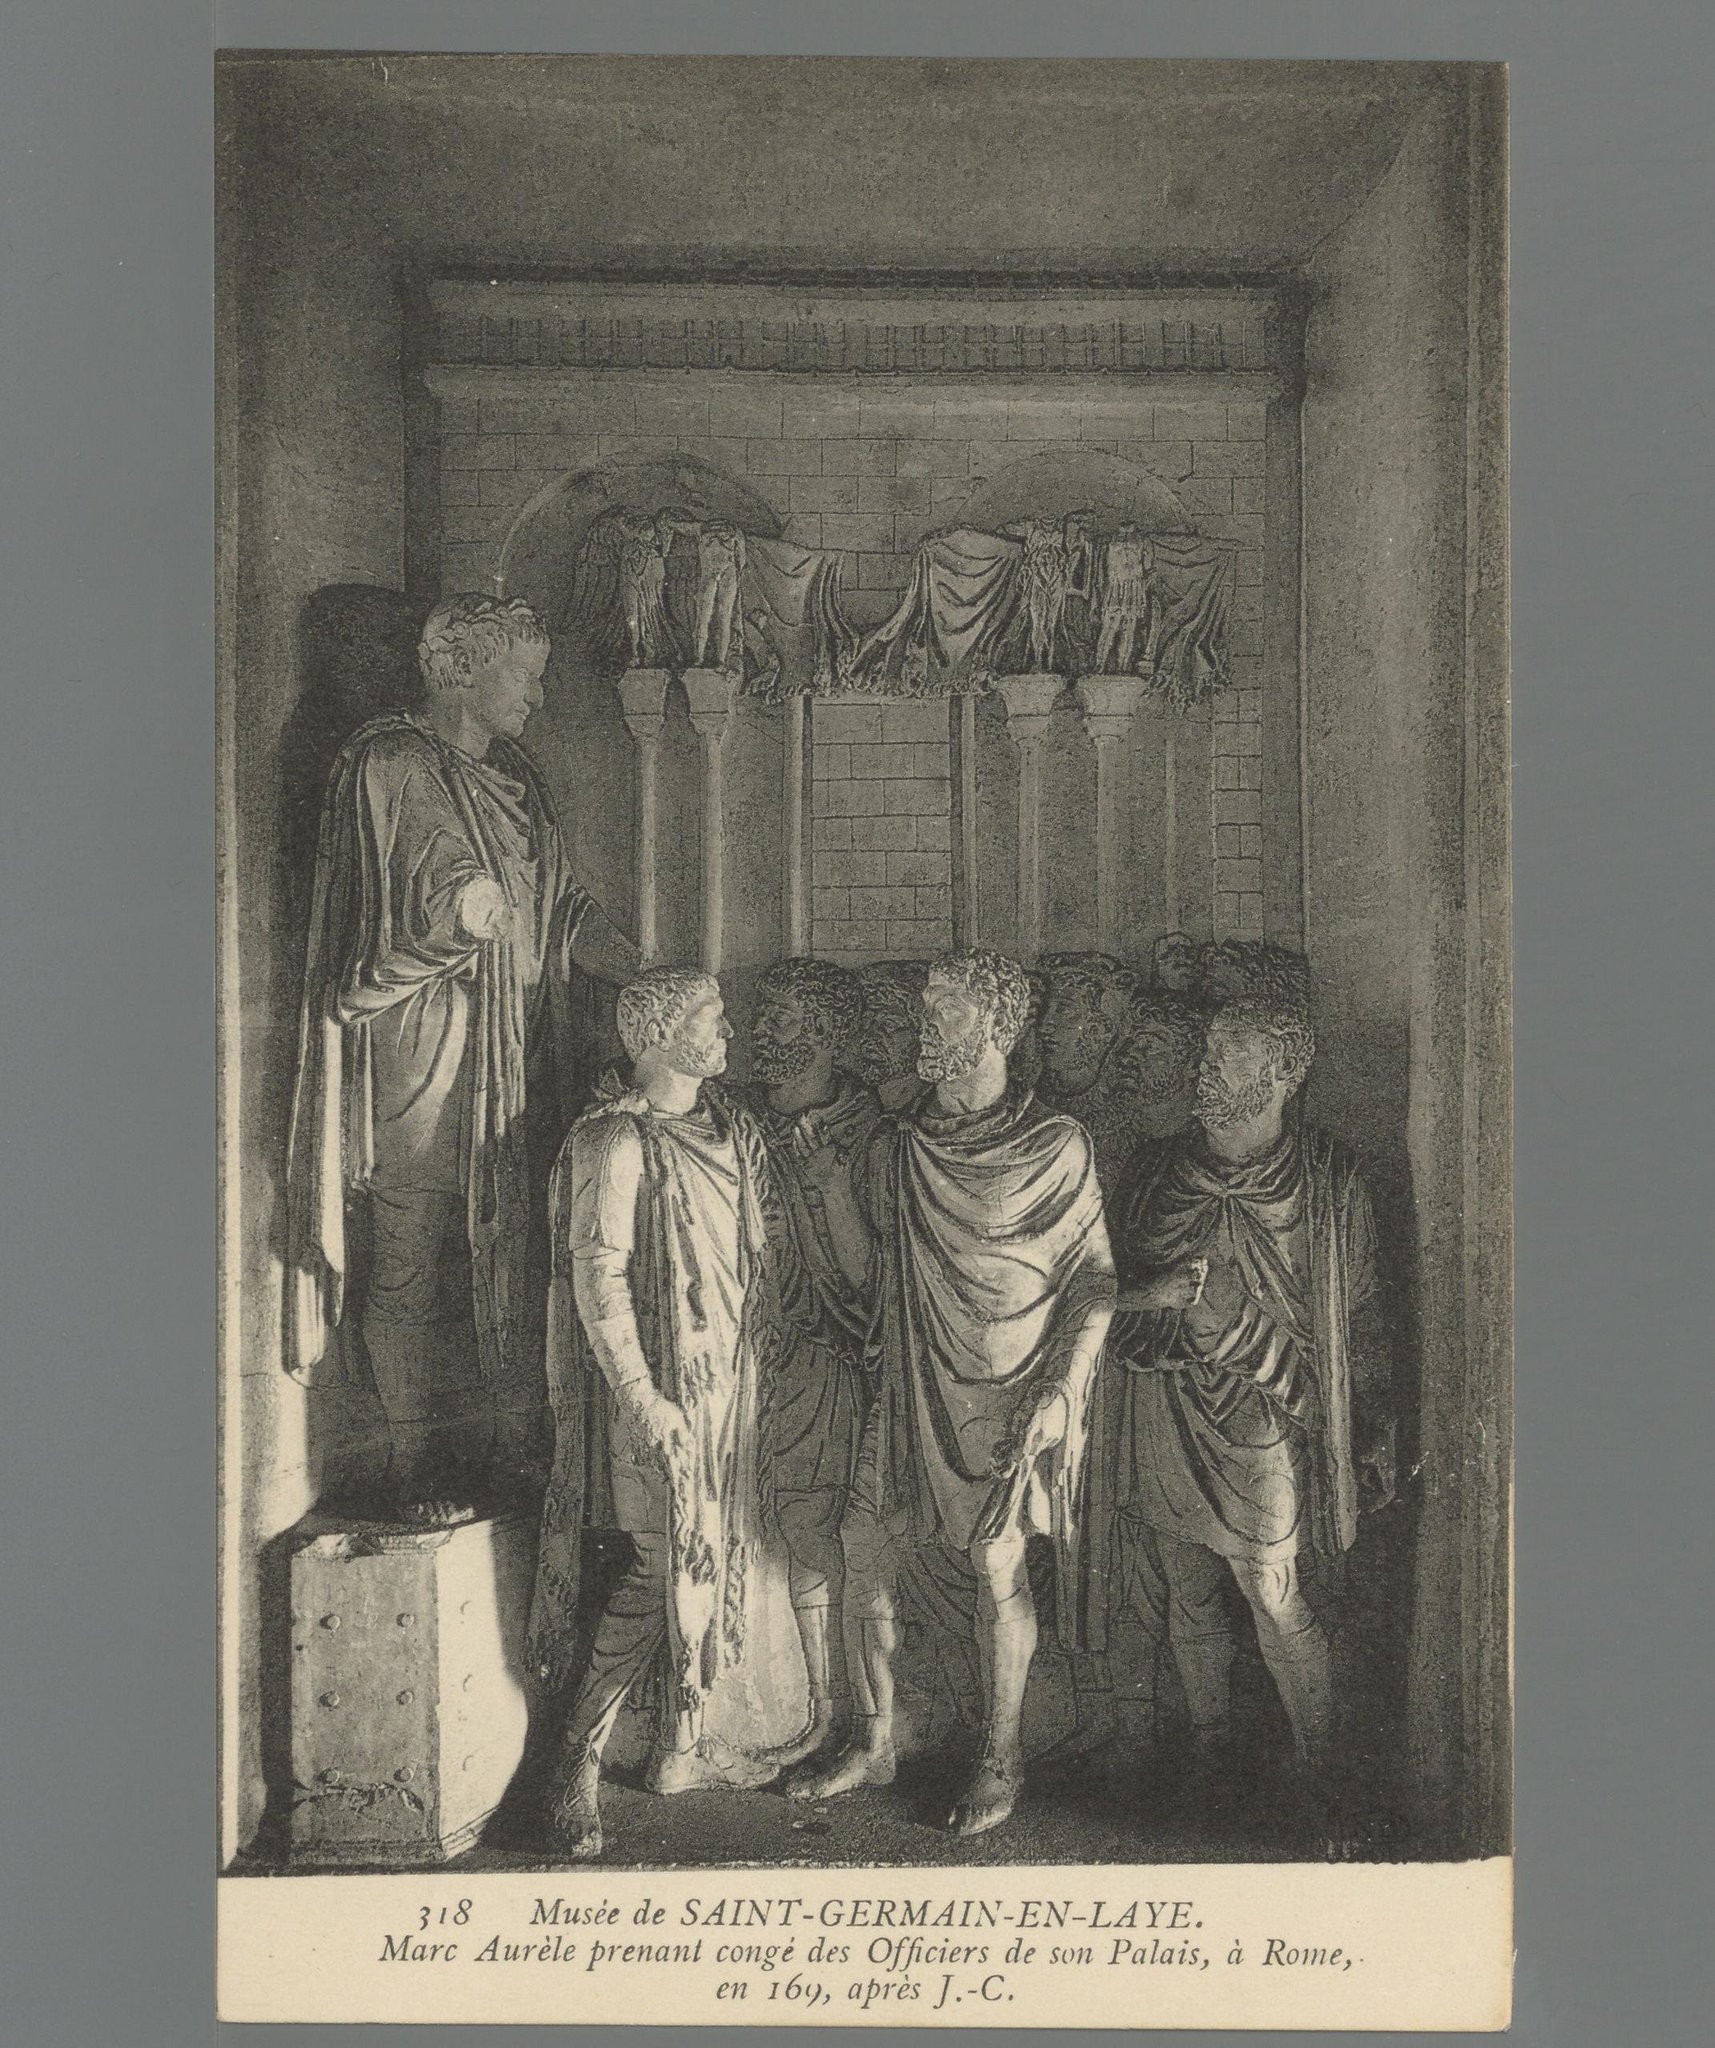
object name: photomechanical print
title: Marc Aurèle prenant congé des Officiers de son Palais, à Rome, en 169, après J.-C.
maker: Anonymous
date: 1903-1918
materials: cardboard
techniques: photograph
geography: saint-germain-en-laye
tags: rome, permanent exhibition, museum, sculpture